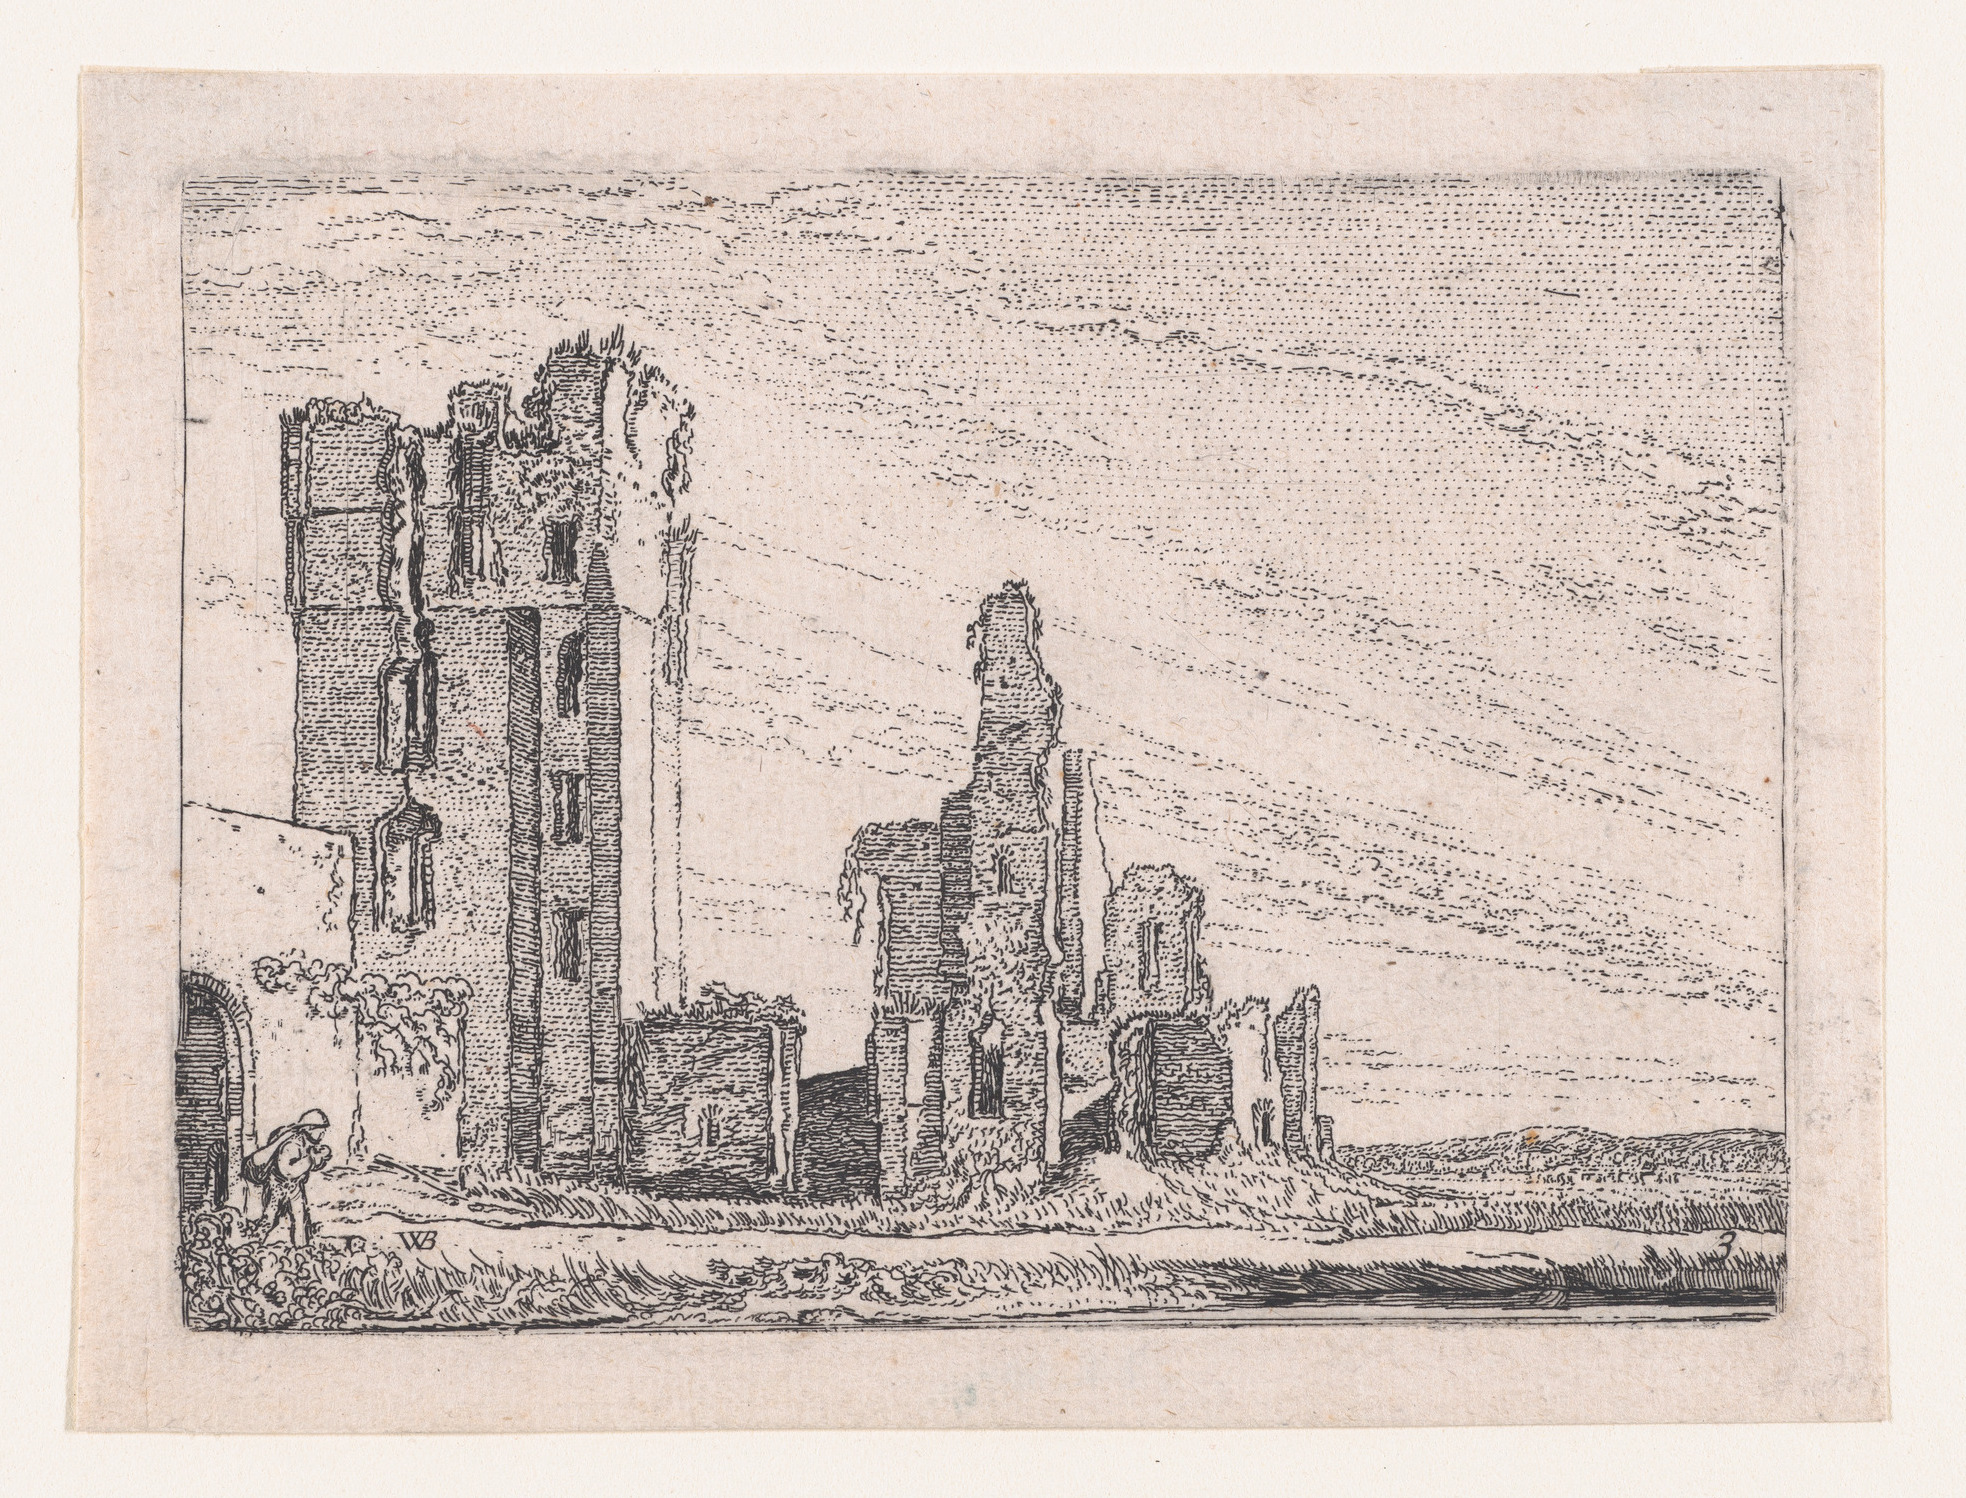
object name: print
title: Het Huys te Kleef bij Haarlem, from Verscheyden Landtschapjes (Various Little Landscapes), Plate 3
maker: willem pietersz buytewech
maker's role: artist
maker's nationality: dutch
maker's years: 1591-1624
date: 1616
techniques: etching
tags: ruins